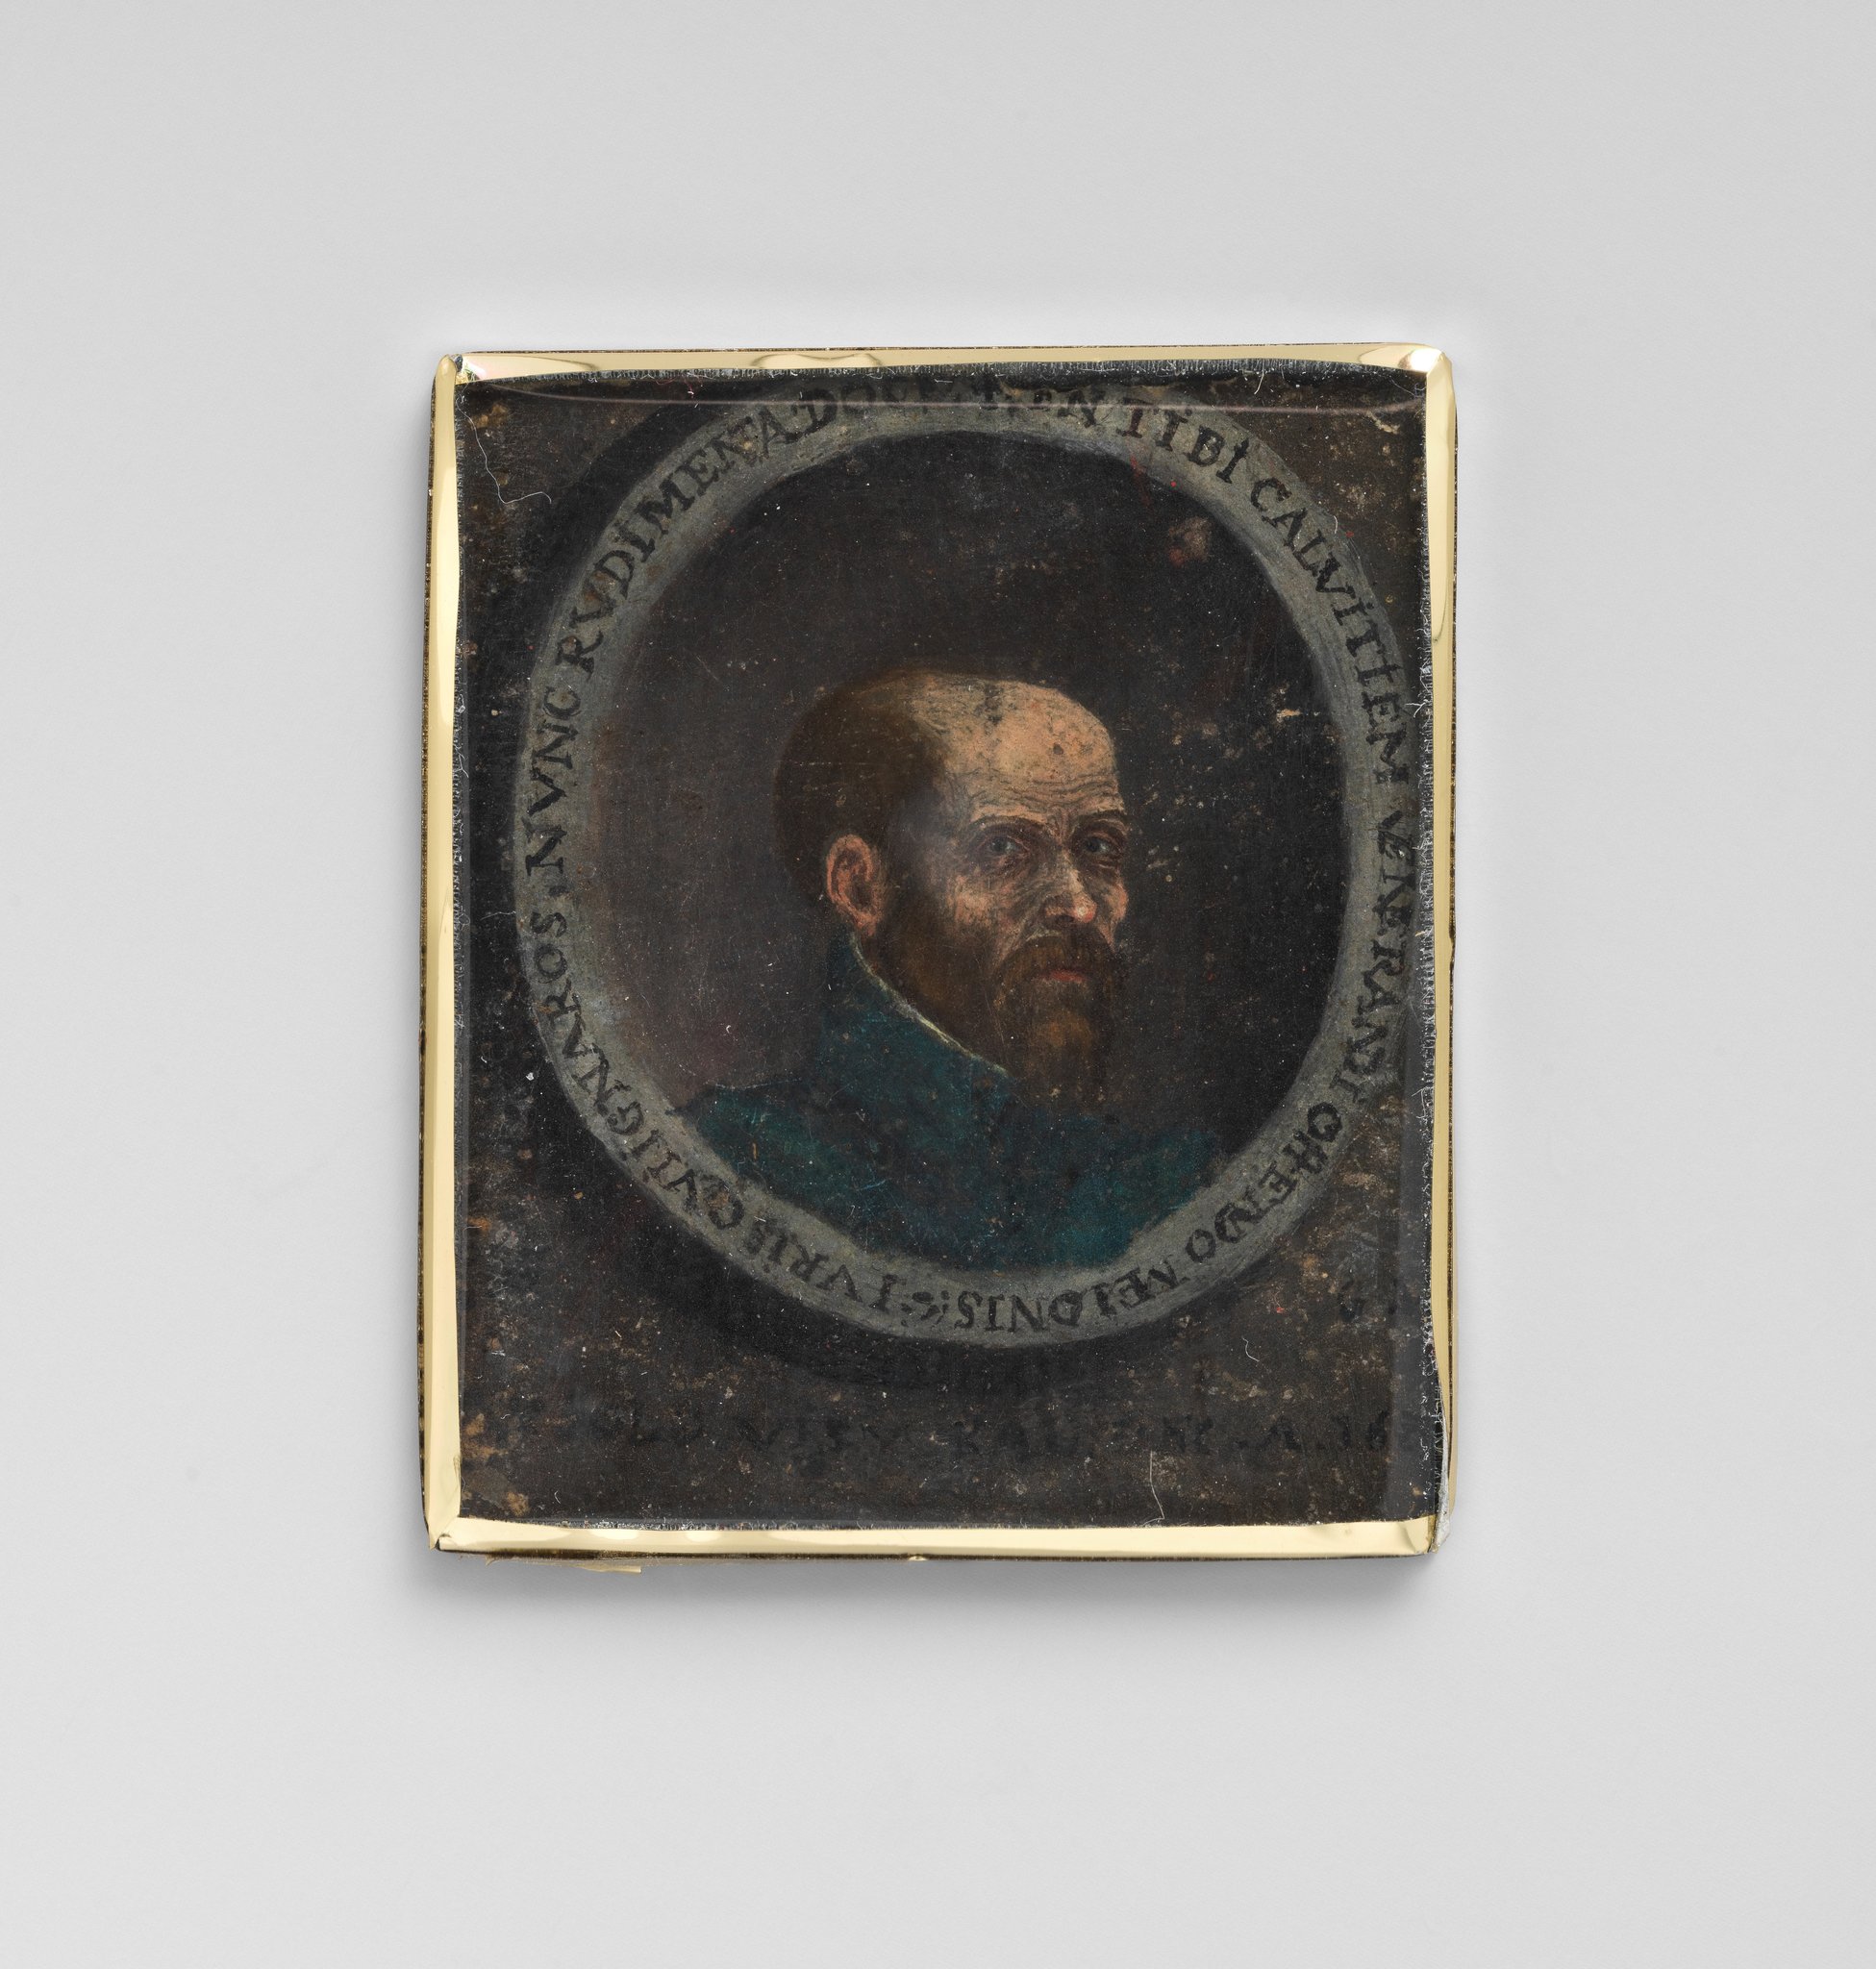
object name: painting, miniature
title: Portrait of a Man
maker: continental painter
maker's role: artist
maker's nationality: continental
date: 1545-1555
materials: oil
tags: men,portraits